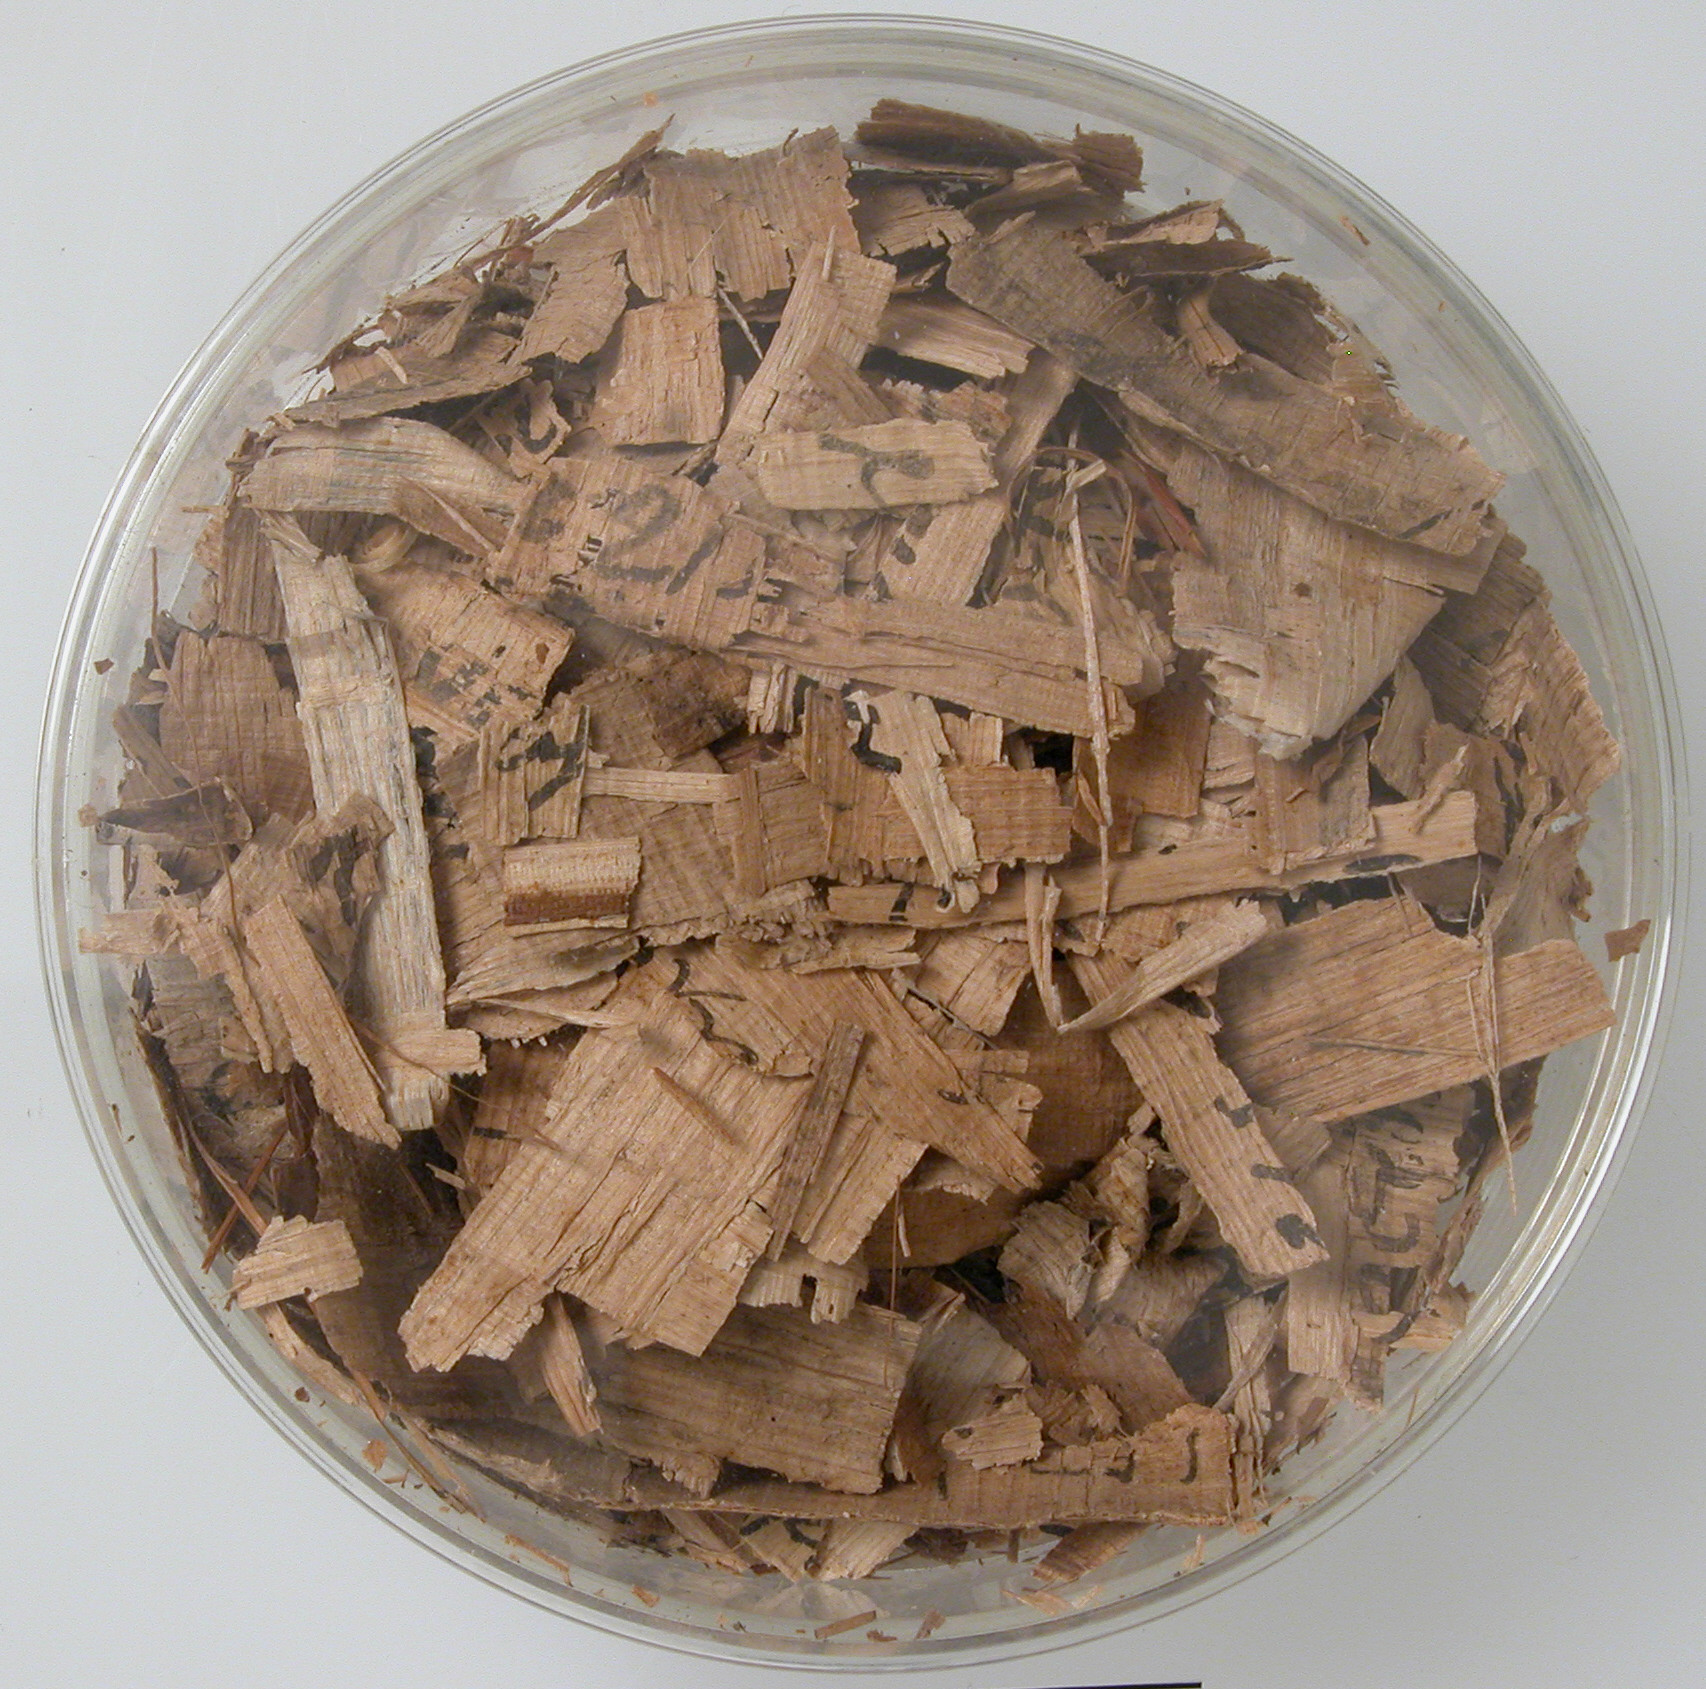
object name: fragment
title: Papyri Fragments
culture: coptic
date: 601-700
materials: ink, papyrus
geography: egypt